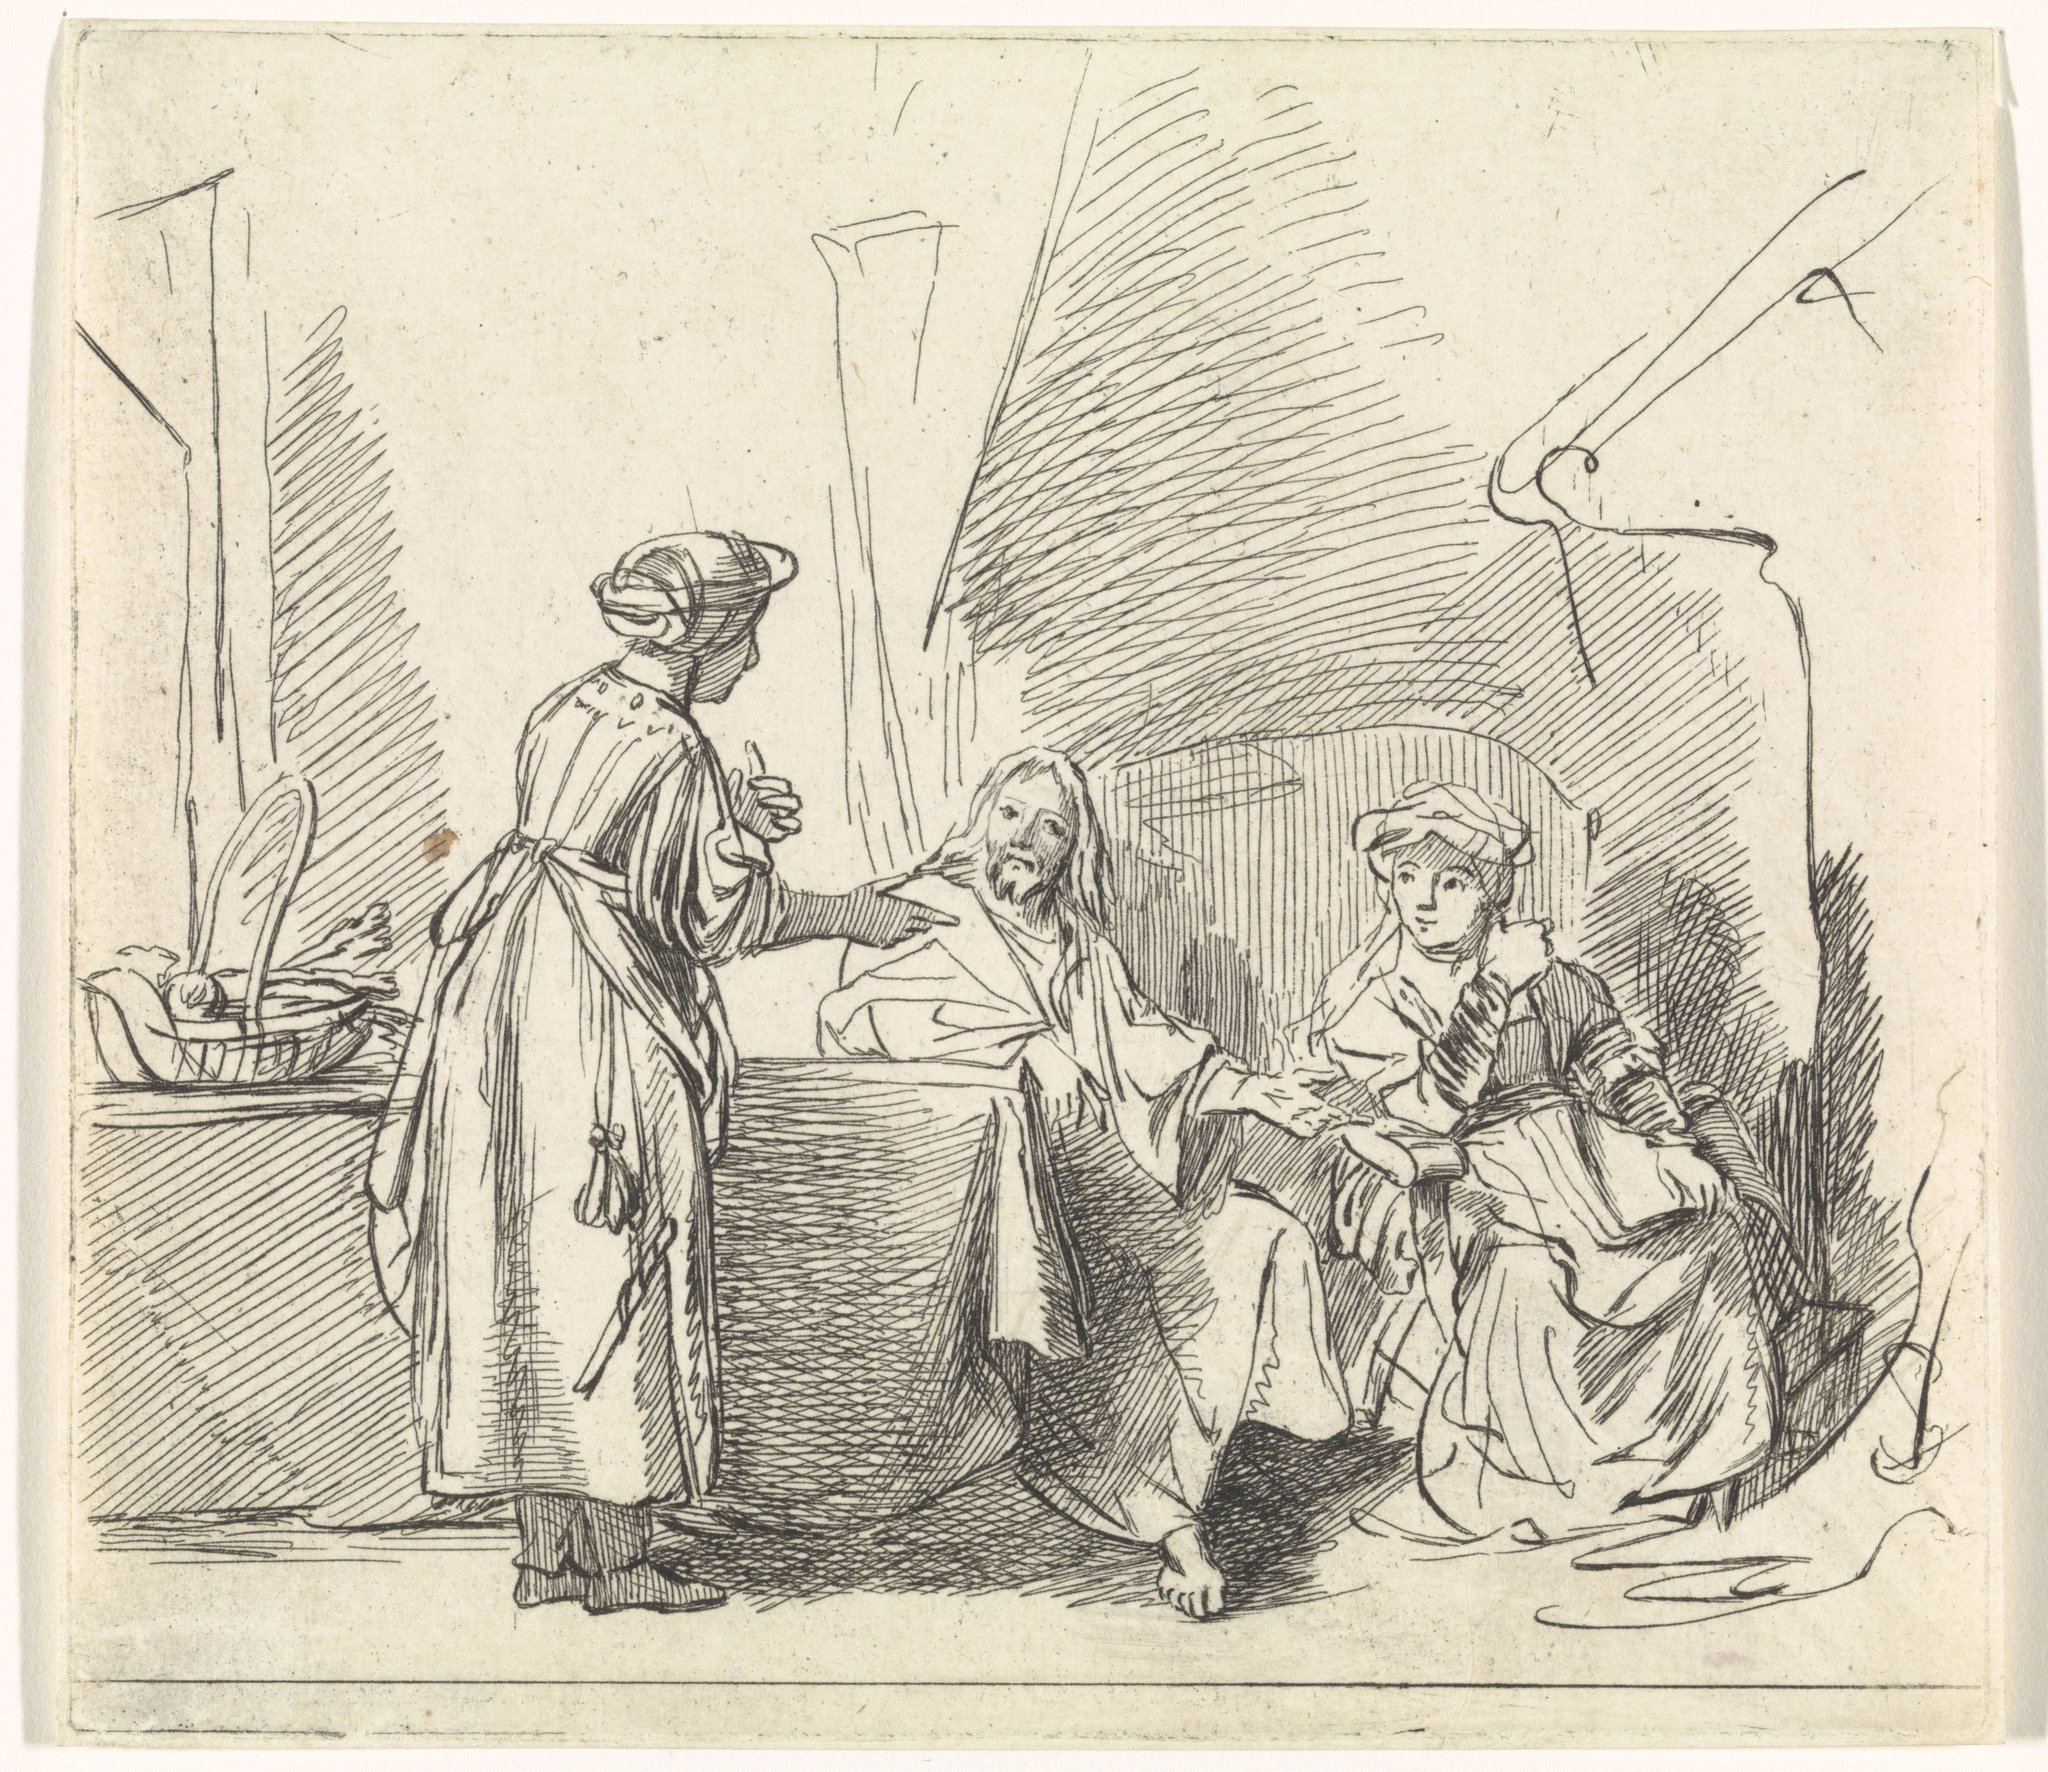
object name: print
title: Christus in het huis van Marta en Maria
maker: bernard picart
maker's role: draughtsman, print maker, publisher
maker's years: 1673-1733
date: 1683-1733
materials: paper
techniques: etching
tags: christ in the house of martha and mary (luke 10:38-42)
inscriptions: collector's mark: Lugt 2228, collector's mark: Lugt 240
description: Definitieve geletterde staat van deze prent opgenomen in: Impostures innocentes, ou recueil d'estampes d'apres divers peintres (...) par Bernard Picart (...) avec son elogue historique et le catalogue de ses ouvrages. Amsterdam: weduwe Bernard Picart, 1734.